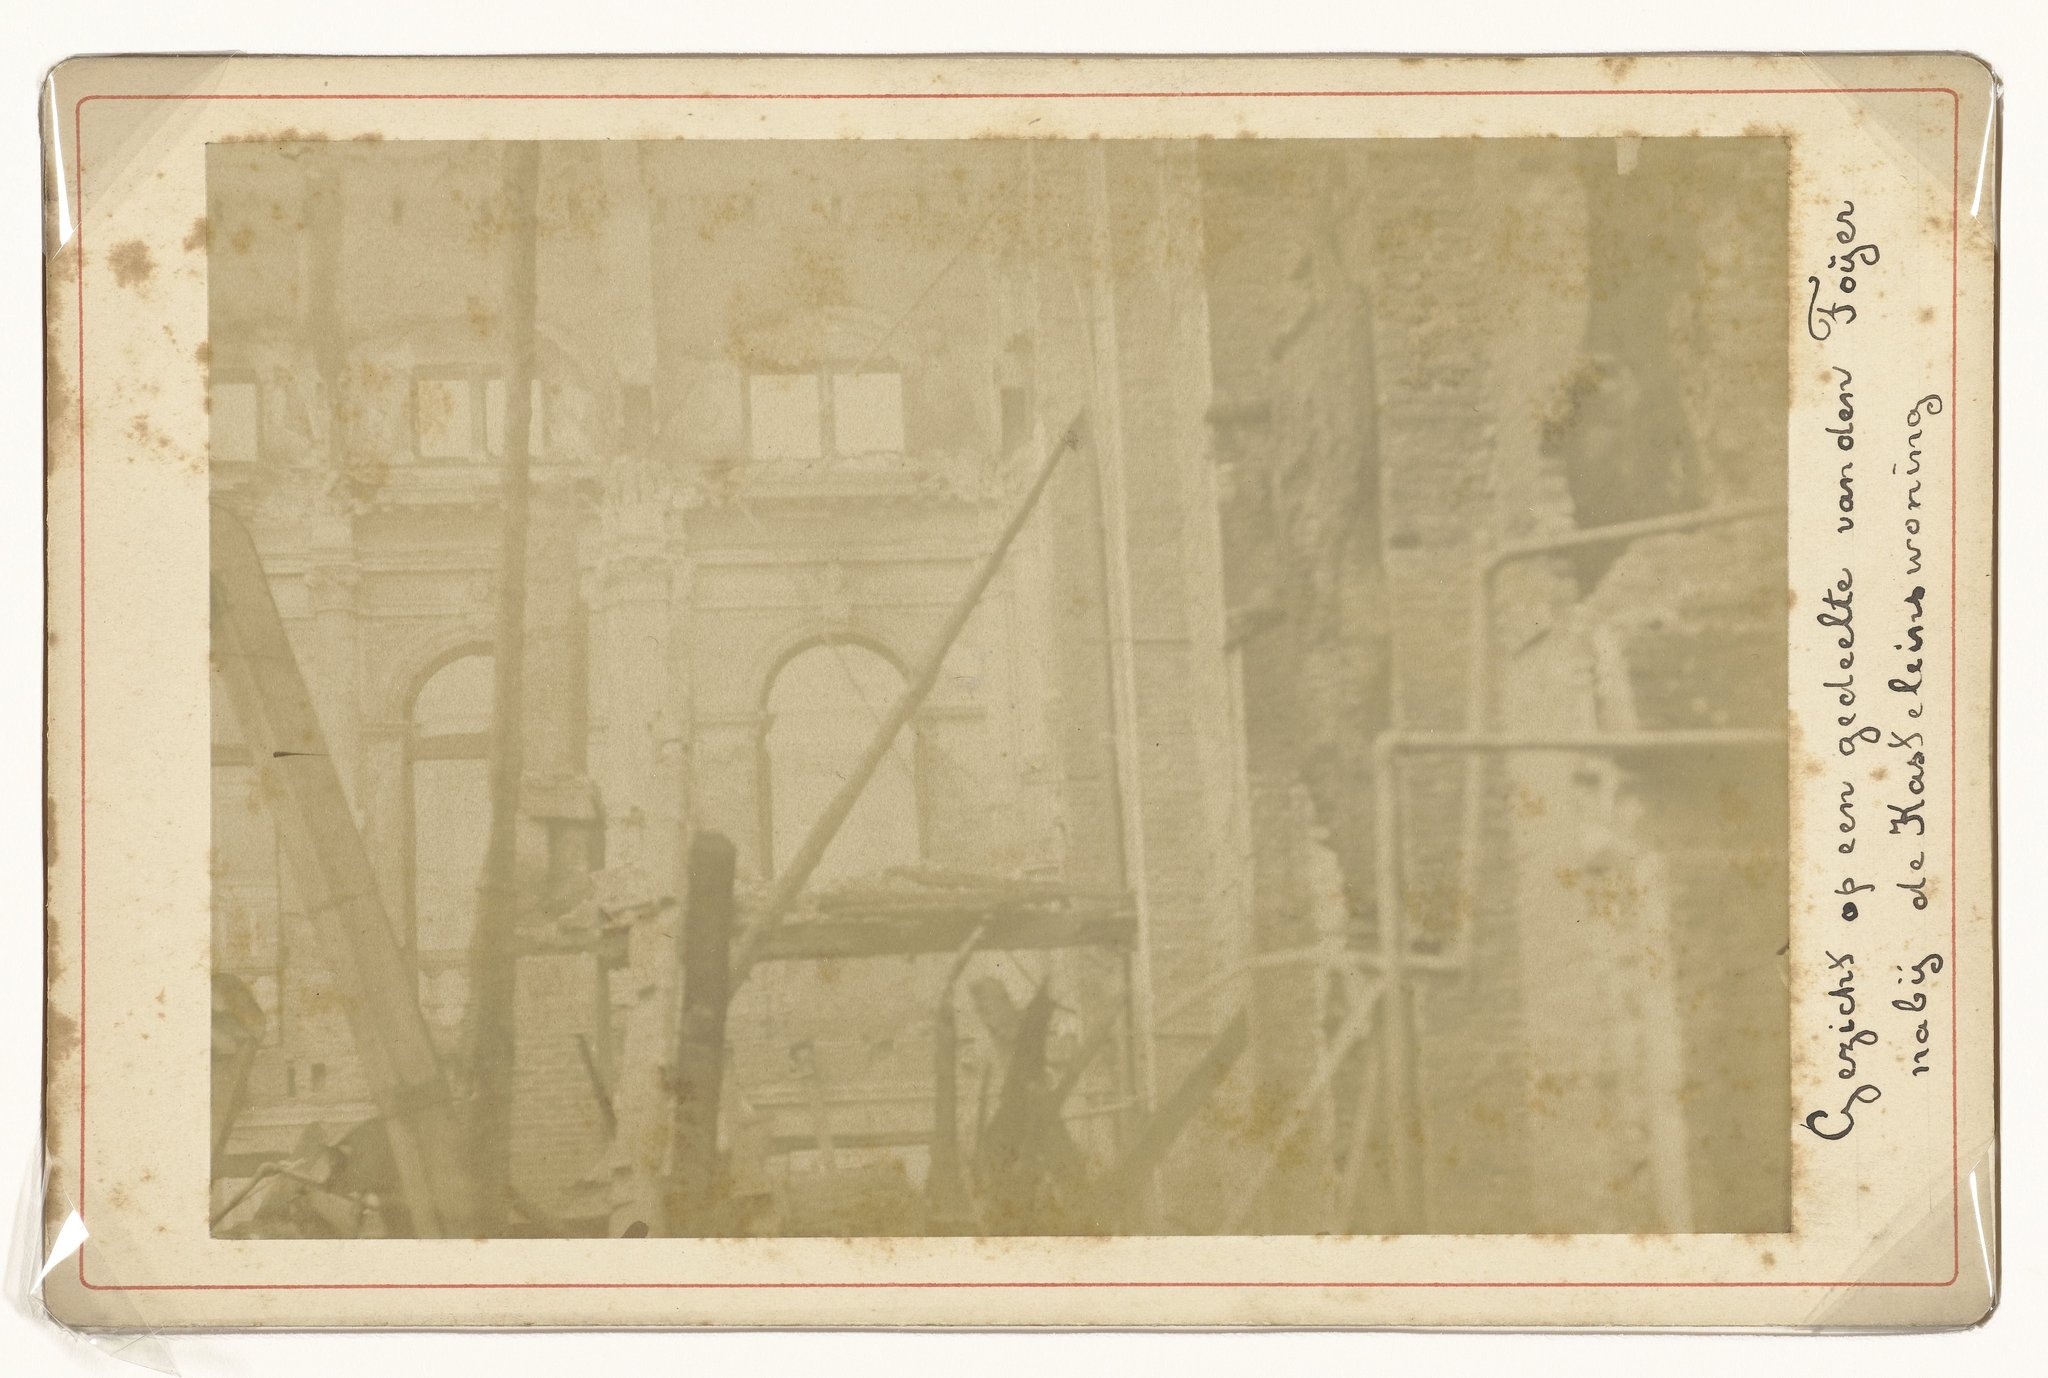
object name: photograph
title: Stadsschouwburg in Amsterdam na brand, 20 februari 1890 (foyer)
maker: christiaan batelt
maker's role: fotograaf, inspecteur van politie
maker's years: 1846-1919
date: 1890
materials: paper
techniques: albumen print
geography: amsterdam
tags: ruin of a building ~ architecture, theatre (building)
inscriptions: annotation: ‘Gezicht op een gedeelte van den foyer nabij de Kasteleinswoning’, annotation: ‘Ruine schouwburg 20 februari 1890’, signature: ‘C. Batelt Amsterdam’